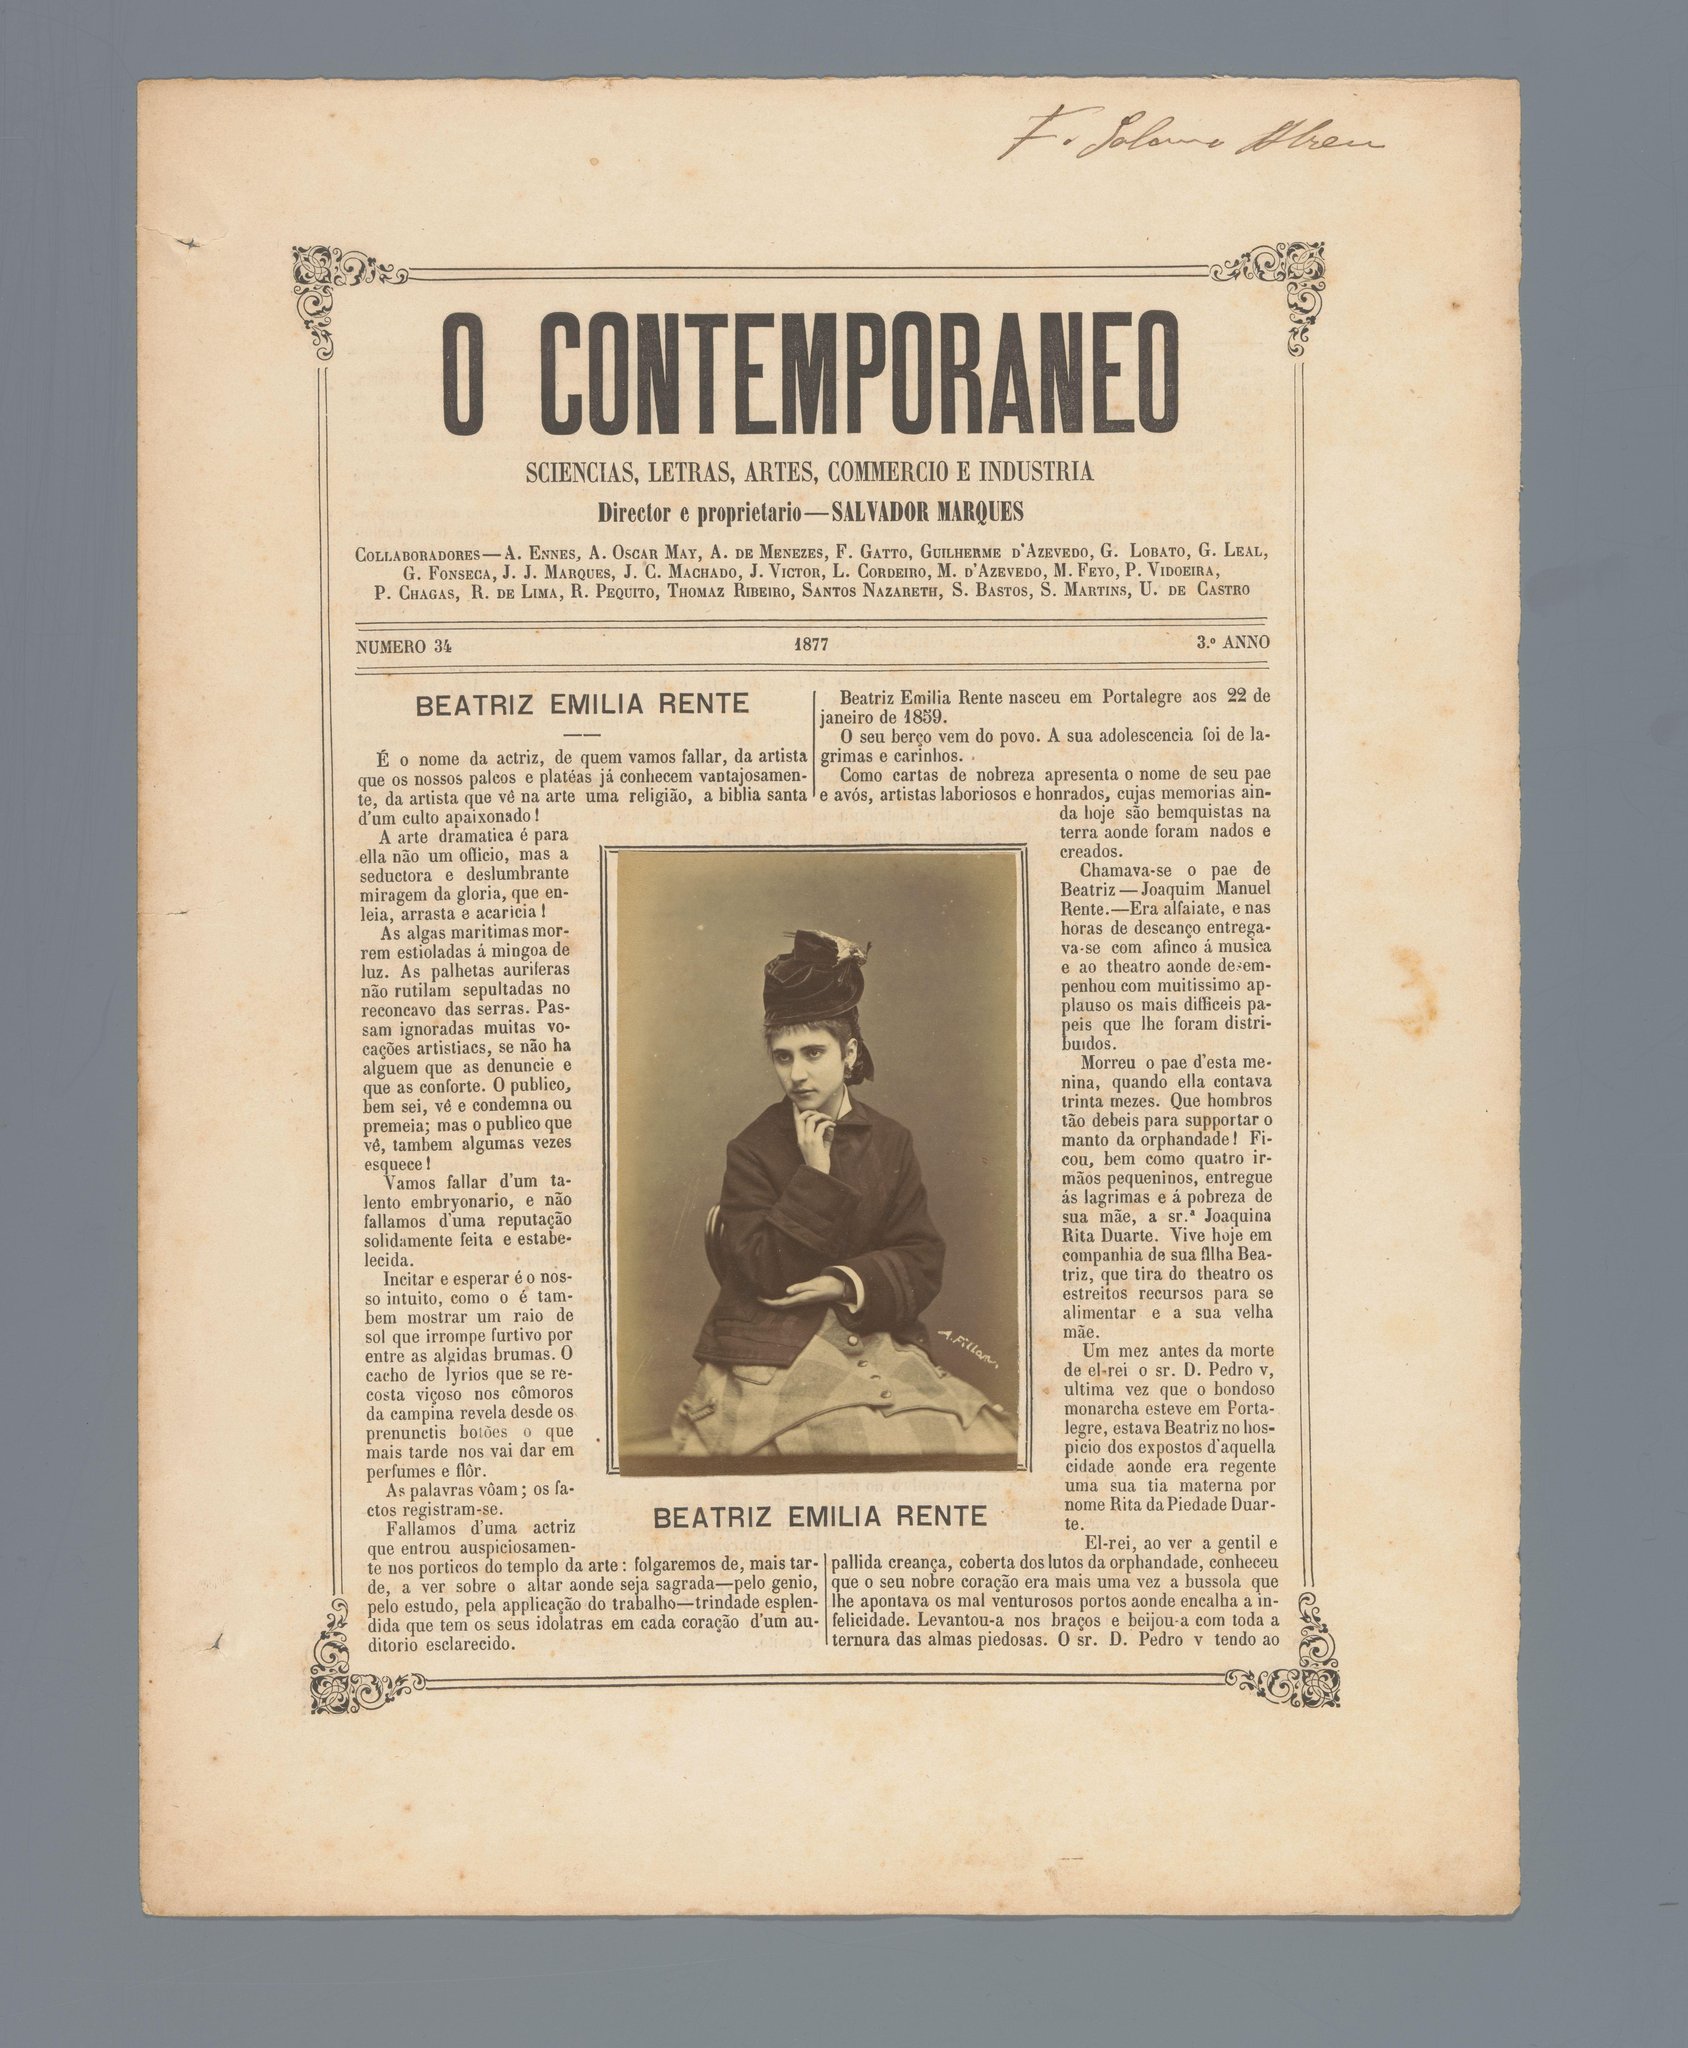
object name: photograph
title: O contemporaneo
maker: alfred fillon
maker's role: fotograaf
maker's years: 1825-1881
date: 1872-1877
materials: paper, photographic support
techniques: albumen print, printing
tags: historical persons - bb - woman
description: Op de voorpagina bevindt zich een portret van Beatriz Emilia Rente.